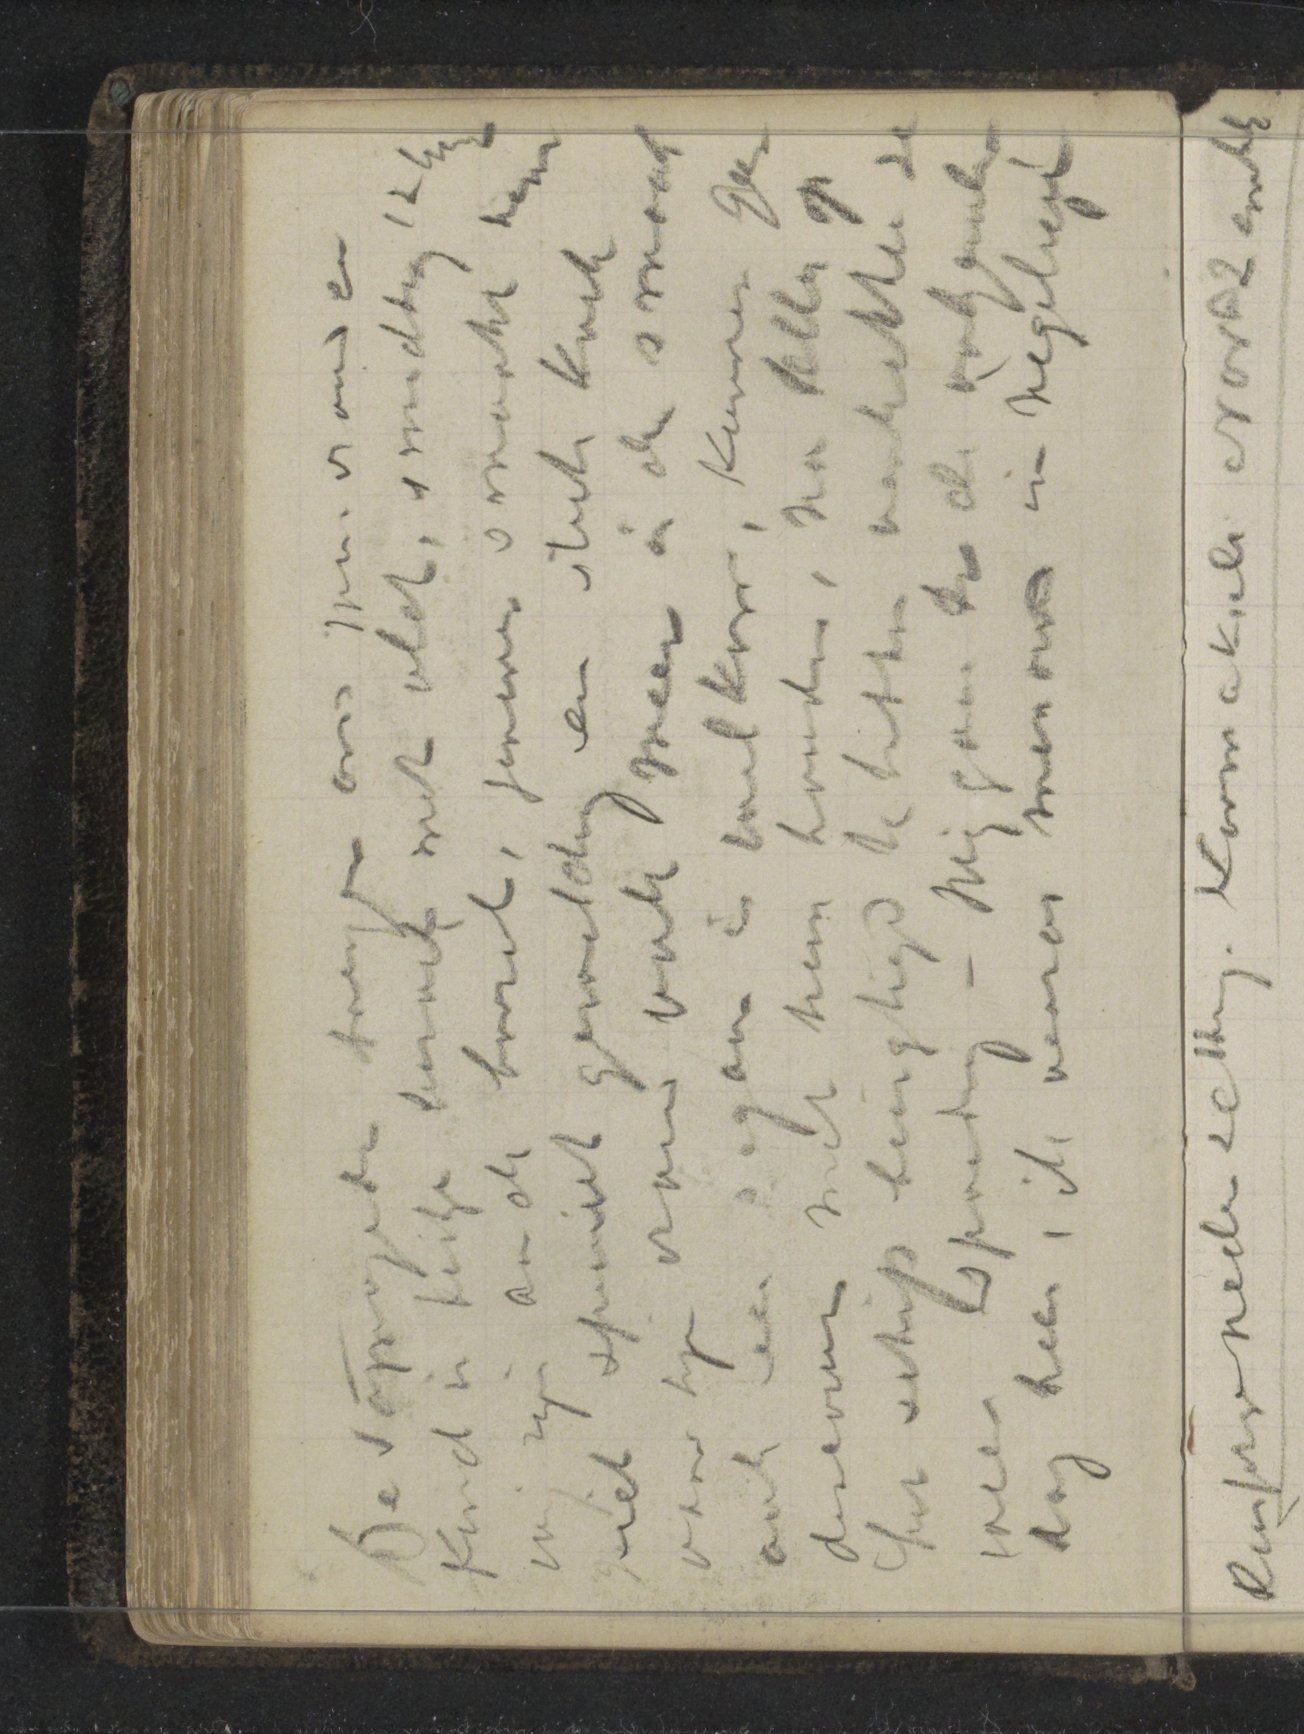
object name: sketchbook leaf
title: Reisverslag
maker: louis apol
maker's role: draughtsman, painter, print maker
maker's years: 1850-1936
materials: pencil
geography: novaya zemlya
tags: nova zembla expedities 1880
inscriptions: annotation: ‘De Samojeden [...]’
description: Blad 52 verso uit een schetsboek met 110 bladen betekend tijdens de expeditie naar Nova Zembla in 1880.